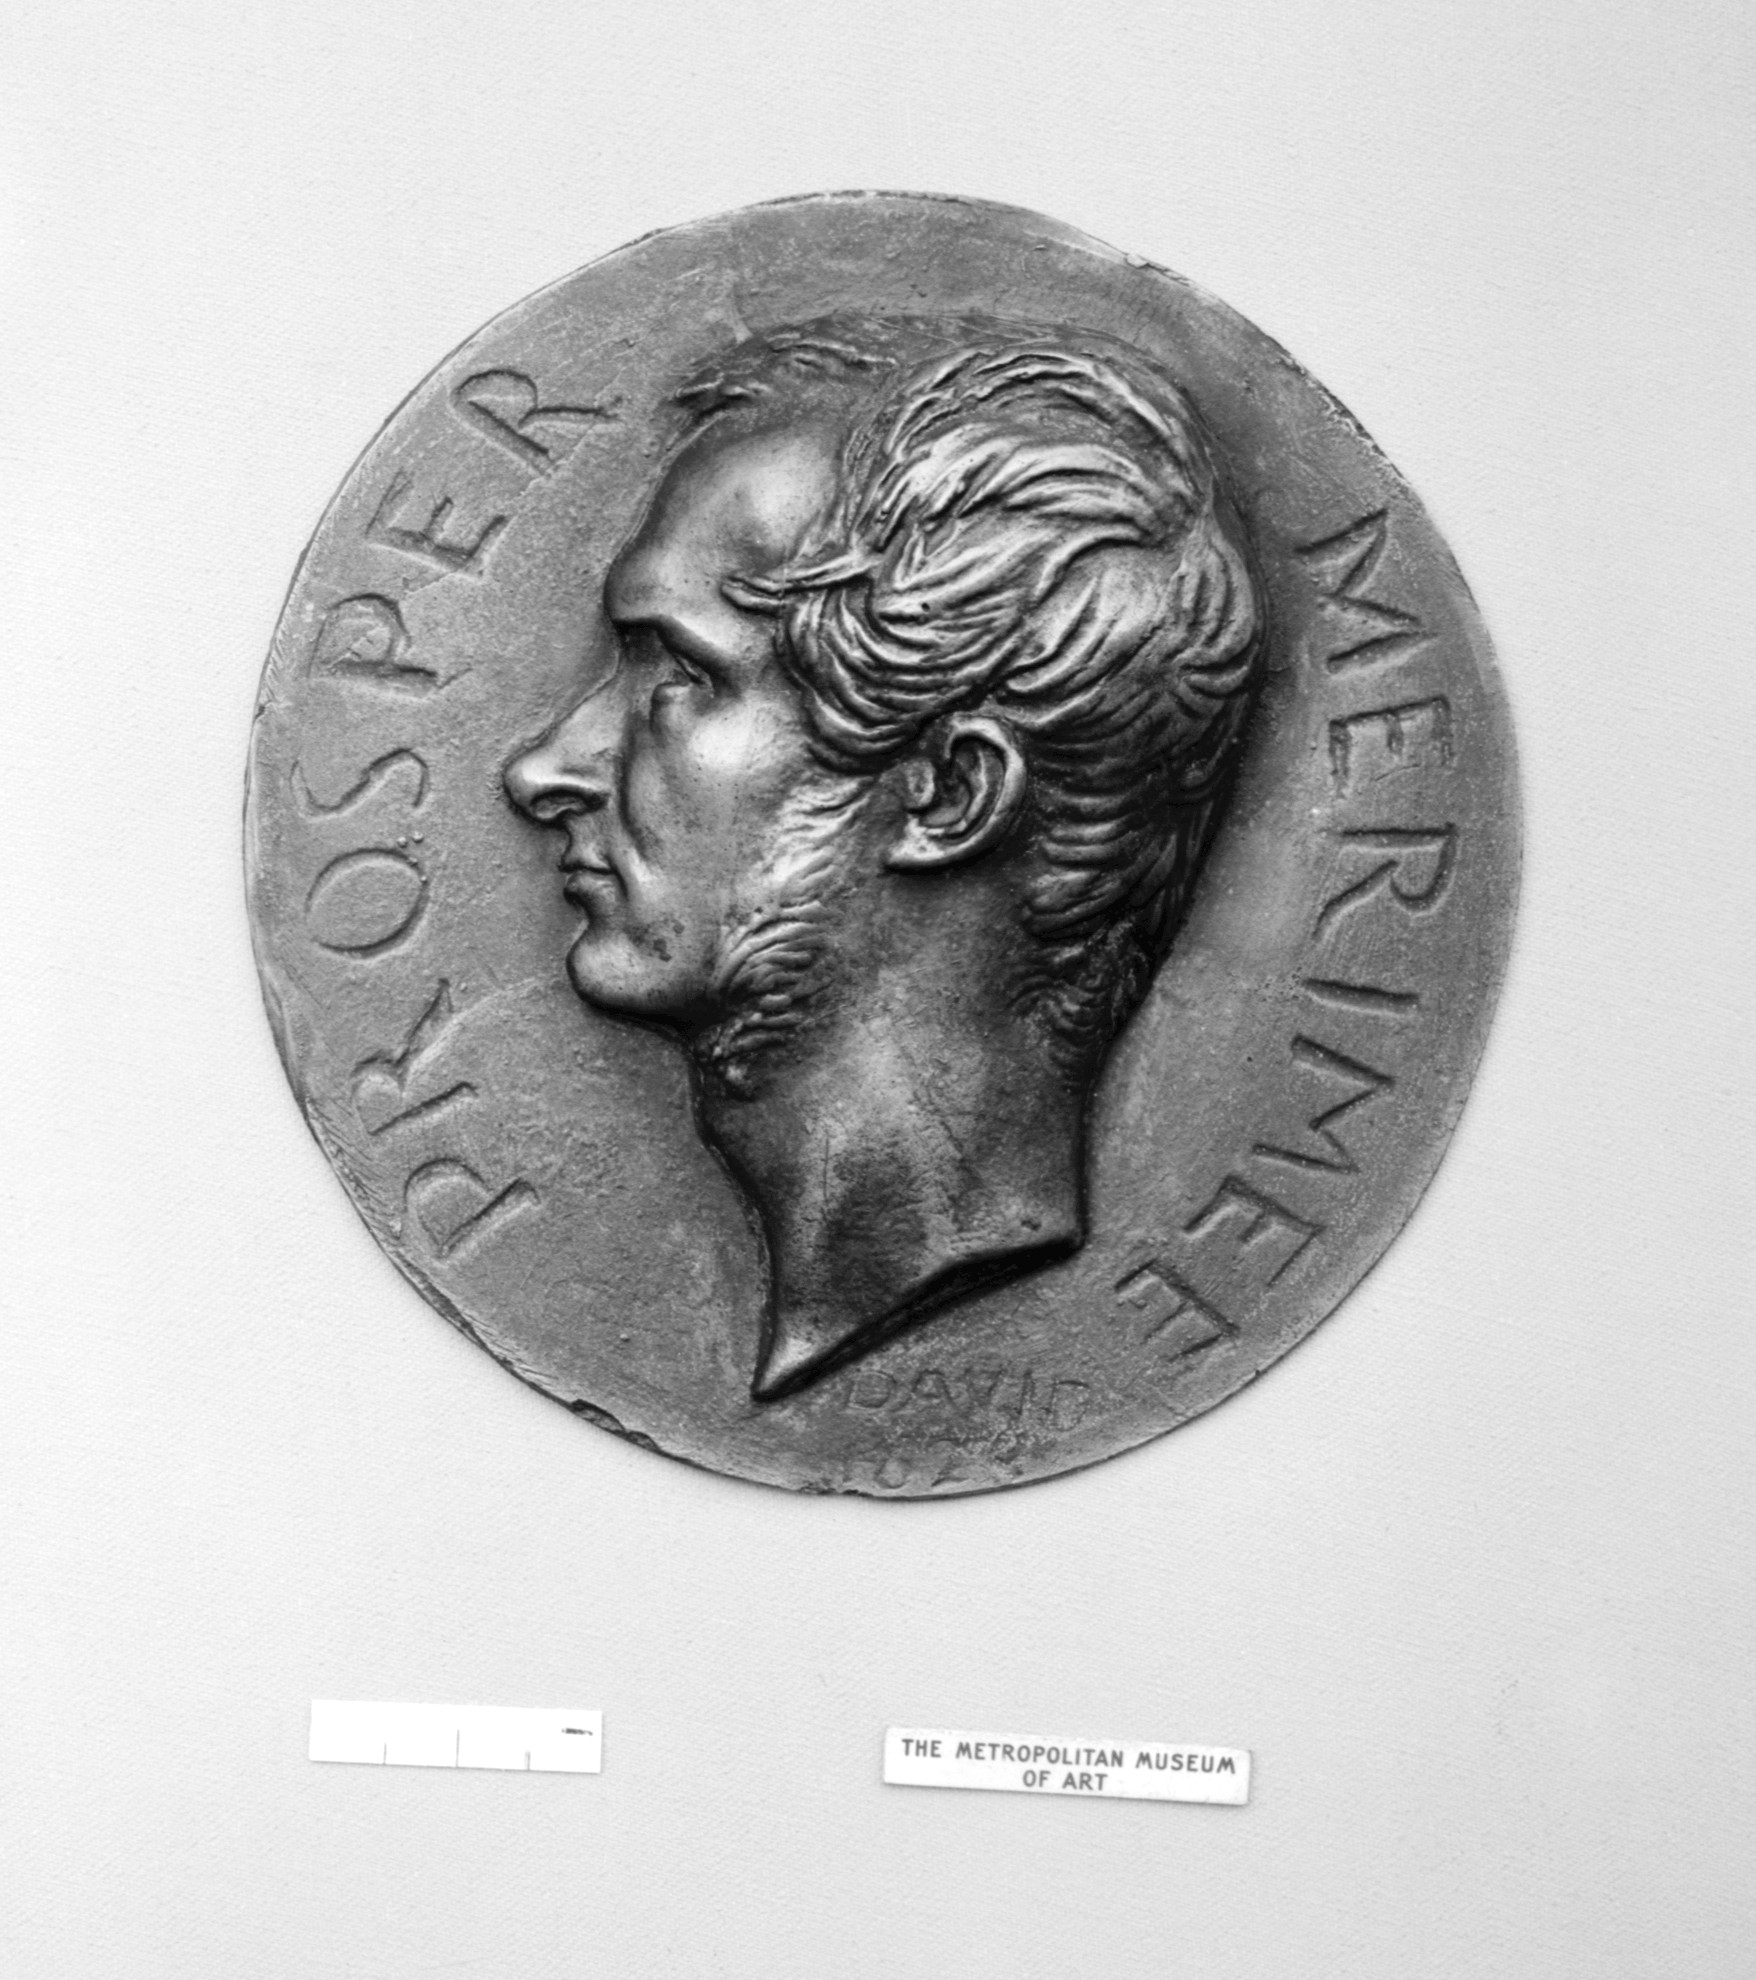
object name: medallion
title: Prosper Merimée (1803–1870), French man-of-letters, historian and novelist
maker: pierre jean david d'angers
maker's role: artist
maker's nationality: french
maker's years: 1788-1856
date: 1828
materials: bronze, patina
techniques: casting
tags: men,profiles